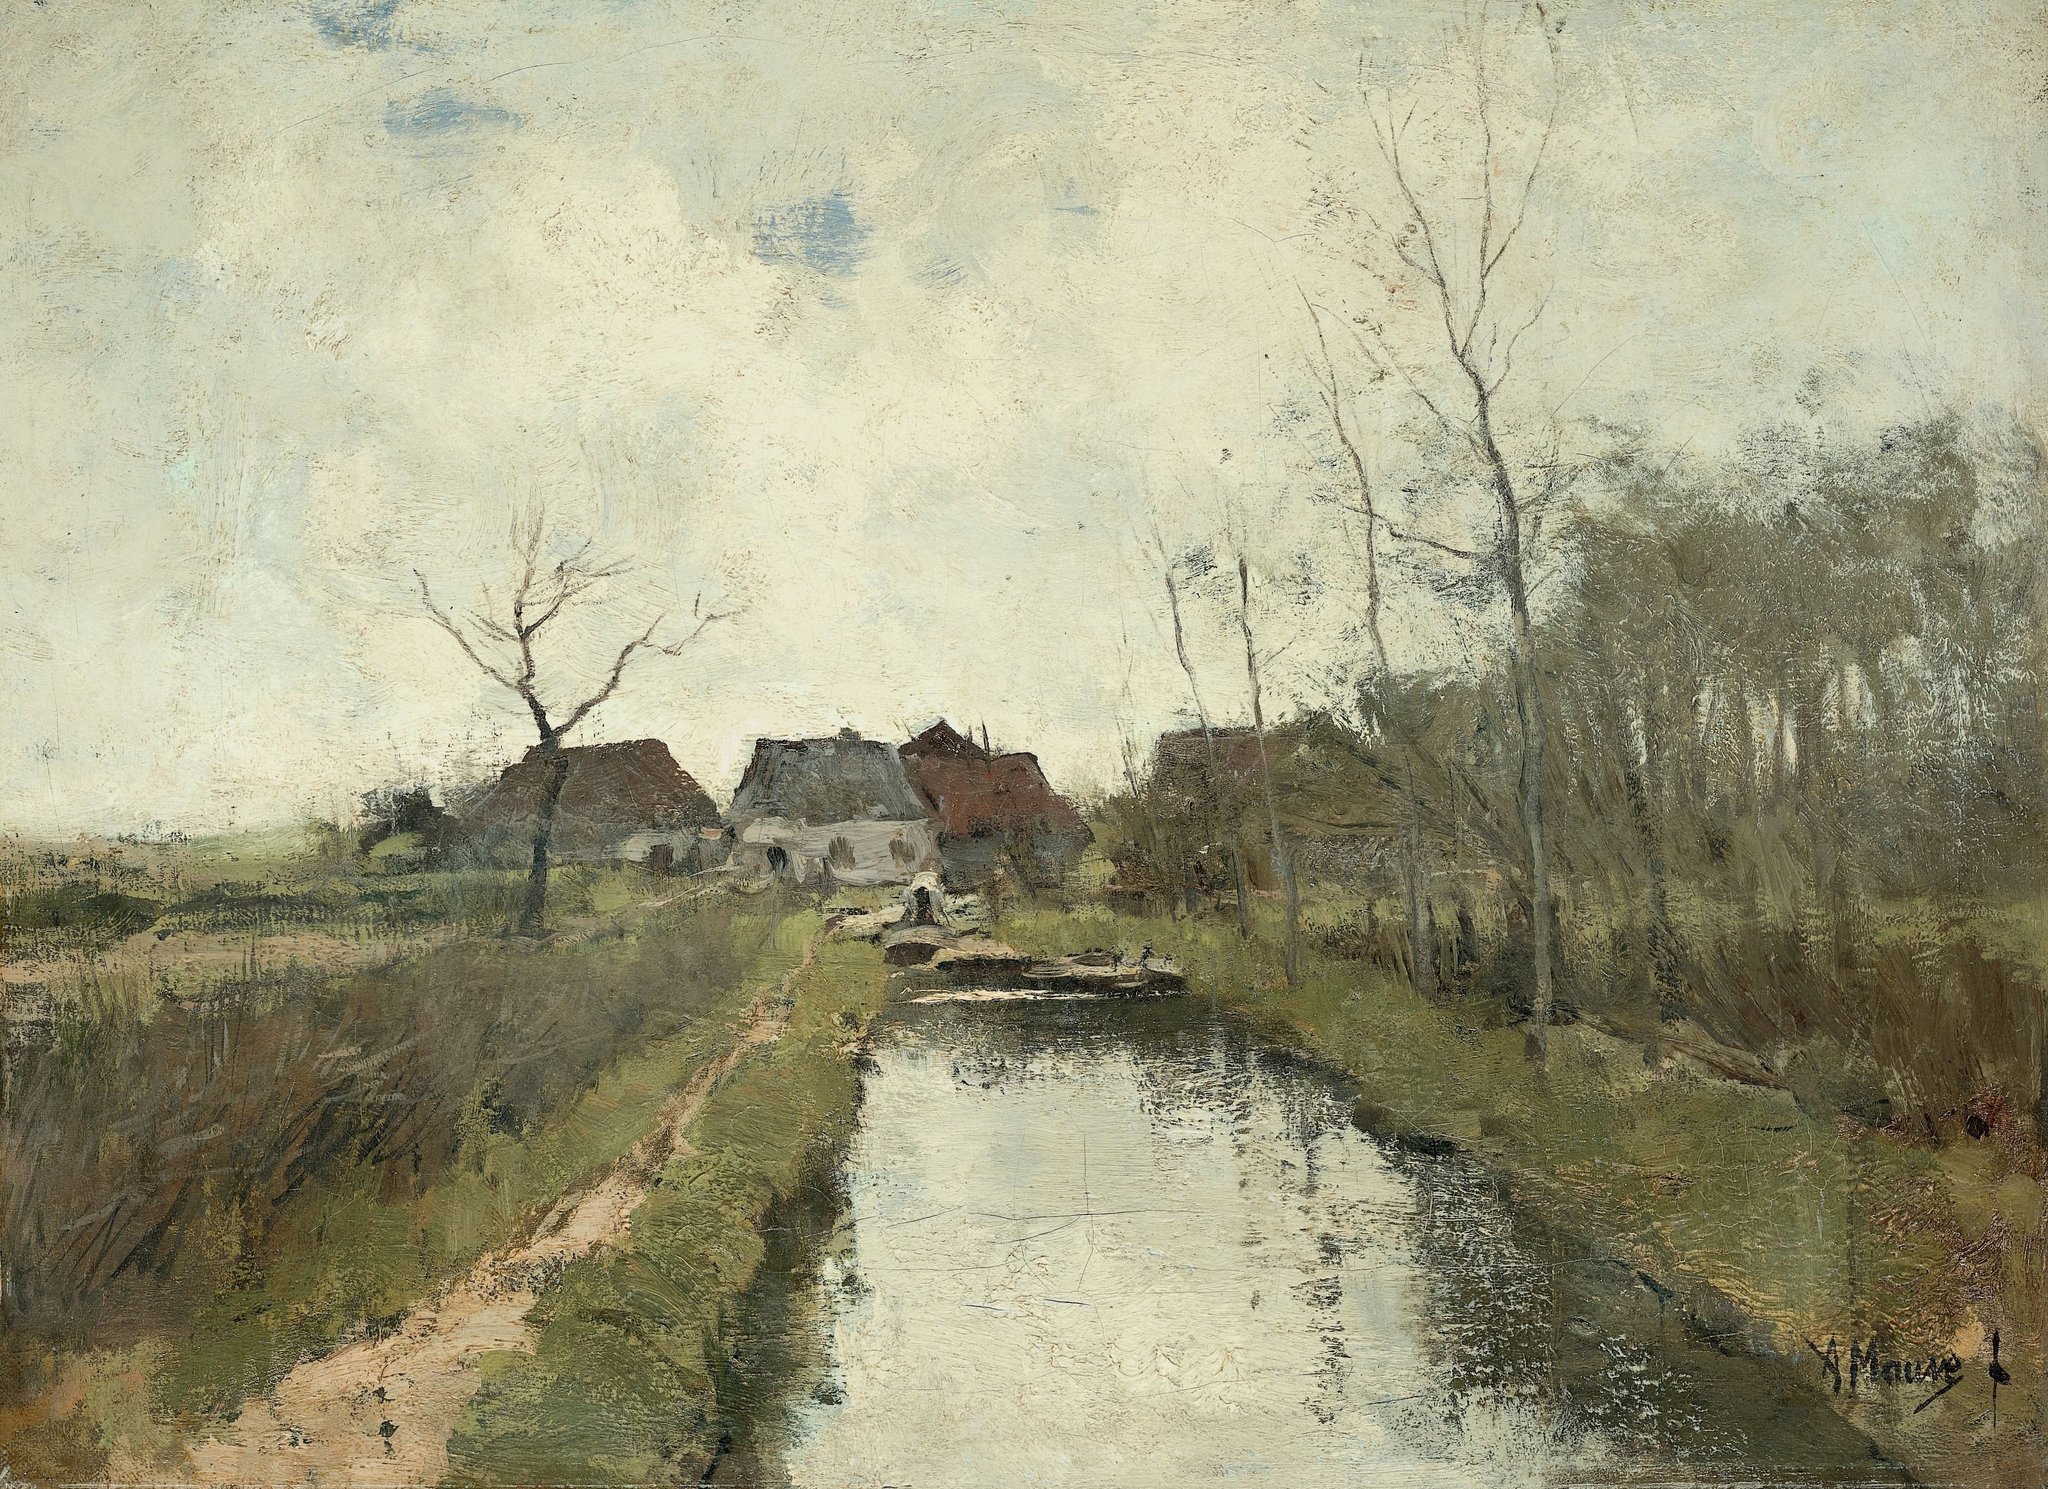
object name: painting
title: Huisje aan een sloot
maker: anton mauve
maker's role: draughtsman, painter, print maker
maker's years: 1838-1888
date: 1870-1888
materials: canvas, oil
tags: small canal, ditch, farm or solitary house in landscape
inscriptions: signature: ‘A Mauve f’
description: Enkele huizen aan het eind van een naar de achtergrond lopende sloot. Rechts enkele rijen bomen.